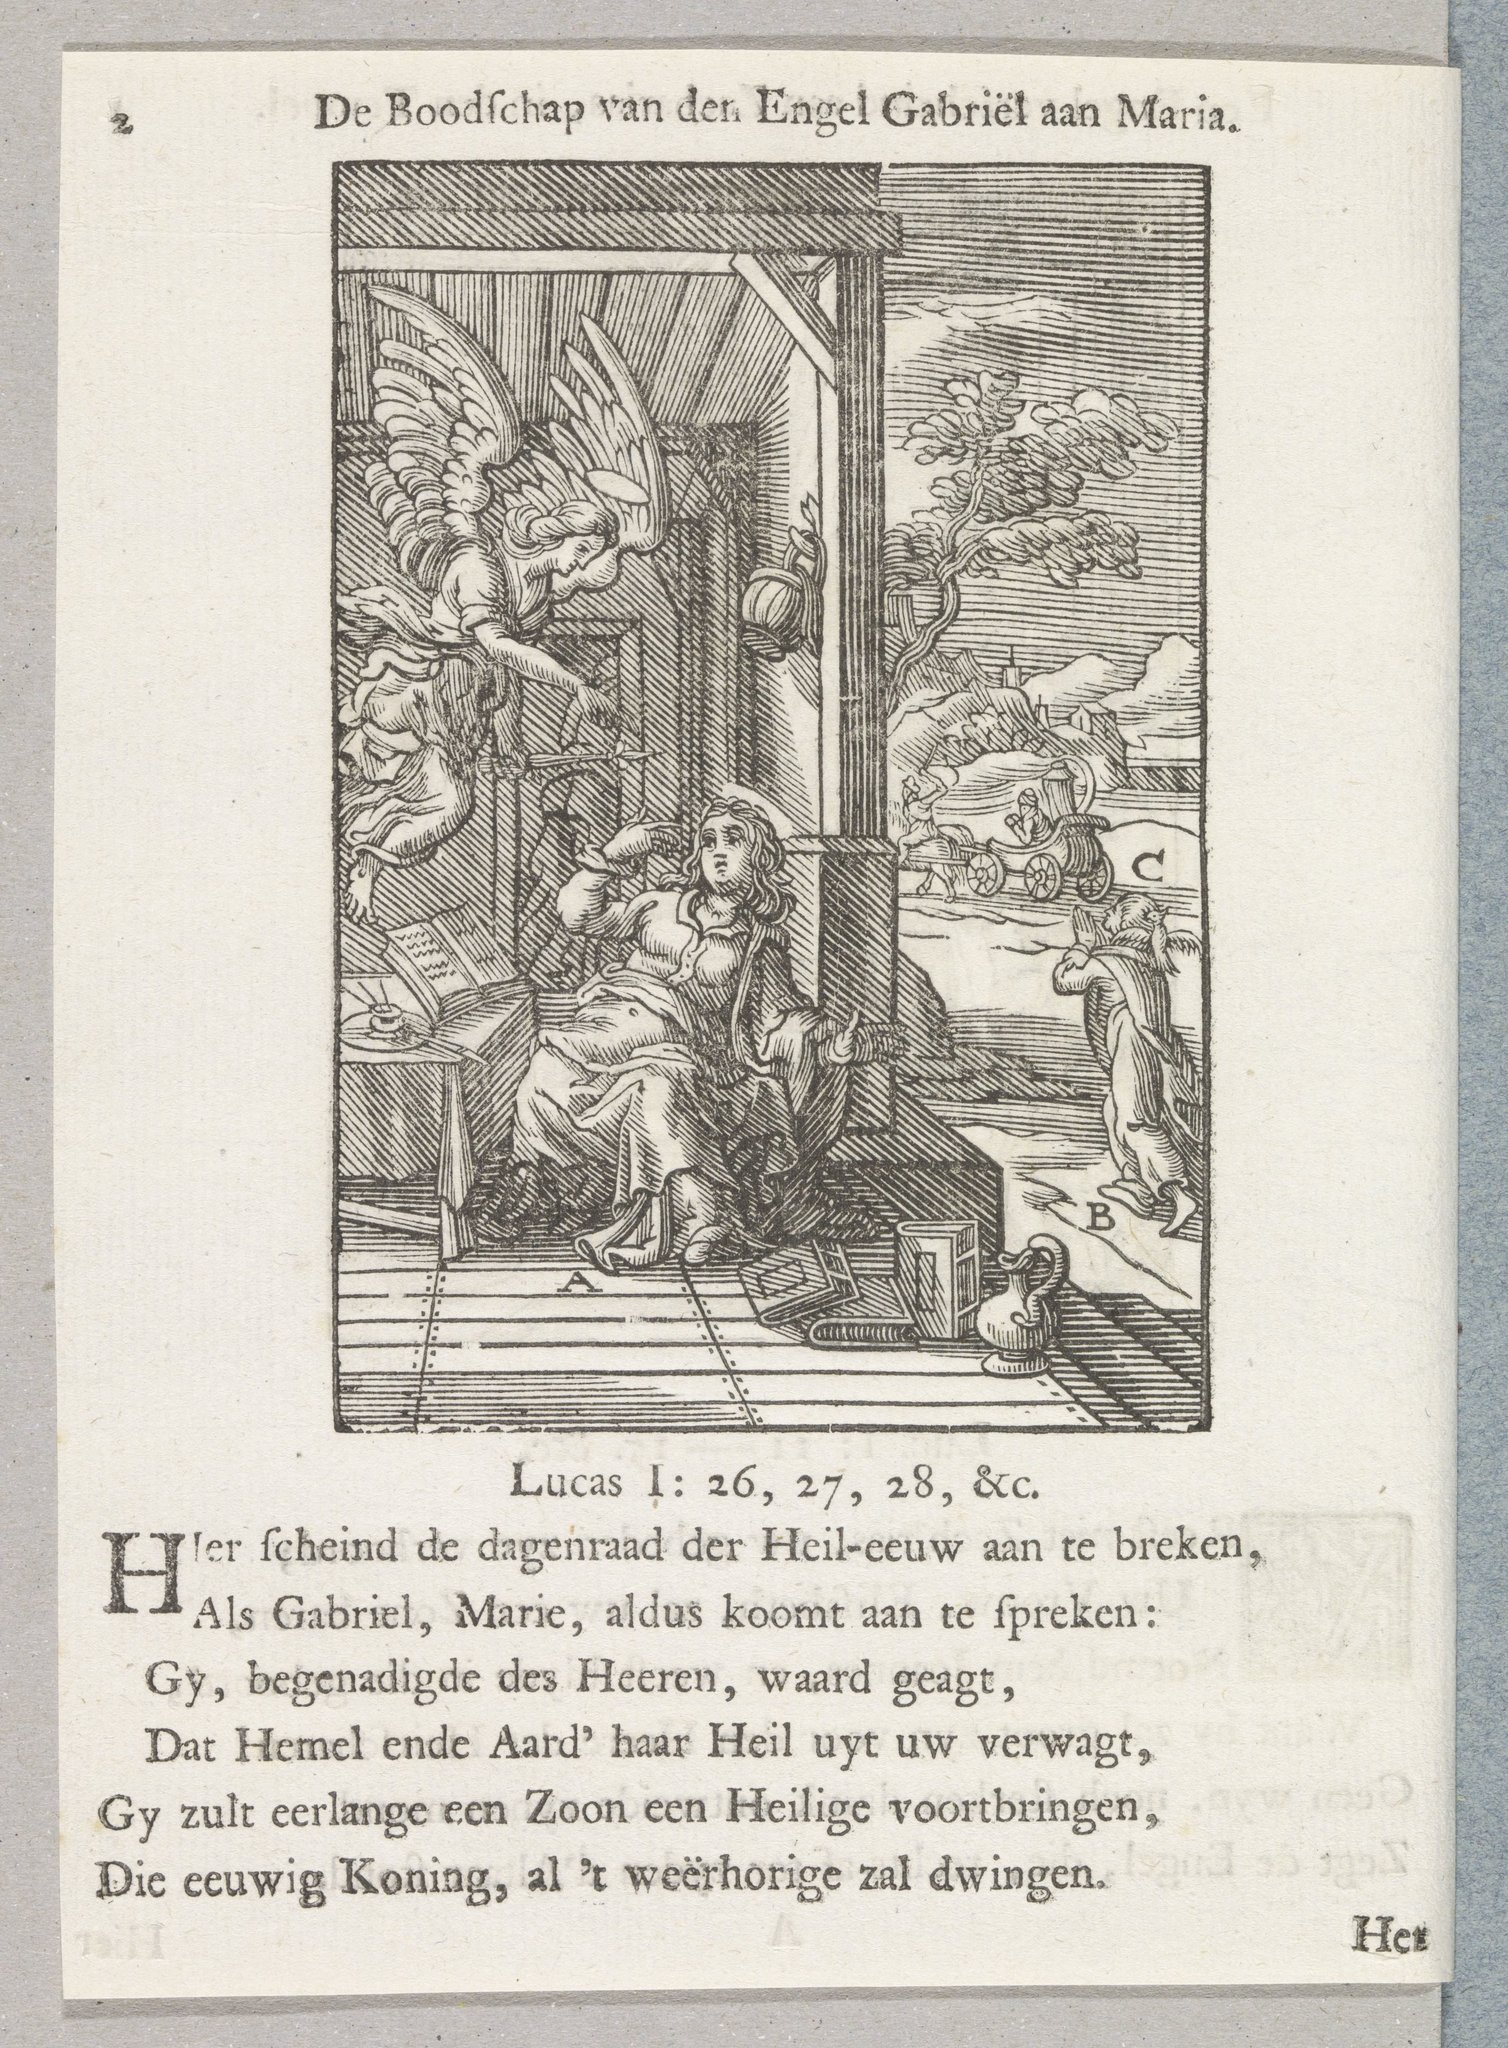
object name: print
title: Fillippus wordt door een engel naar een eunuch gestuurd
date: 1740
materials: paper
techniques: letterpress printing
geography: amsterdam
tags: the annunciation: mary, usually reading, is visited by the angel (sometimes a woman overhears the conversation), philip meets the eunuch, who is travelling in a chariot (+ holy ghost (as dove)), an angel commands philip to go south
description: De prent is afkomstig uit: Bybels Lusthof. Amsterdam, J. Klooster, 1740. De prent werd gemaakt voor de uitgaven van P.J. Paets uit Amsterdam, verschenen in de jaren 1629-1648. De prent wordt mogelijk al voor het eerst gebruikt in: Der Zielen Lust-hof. Leuven, I.Jacbosz voor P.J. Paets [= Amsterdam, P.J. Paets], 1629. Ze komt in ieder geval voor in: Het Nieuwe Testament ons Salichmaeckers Jesu Christi. Amsterdam, P.J. Paets, 1646.